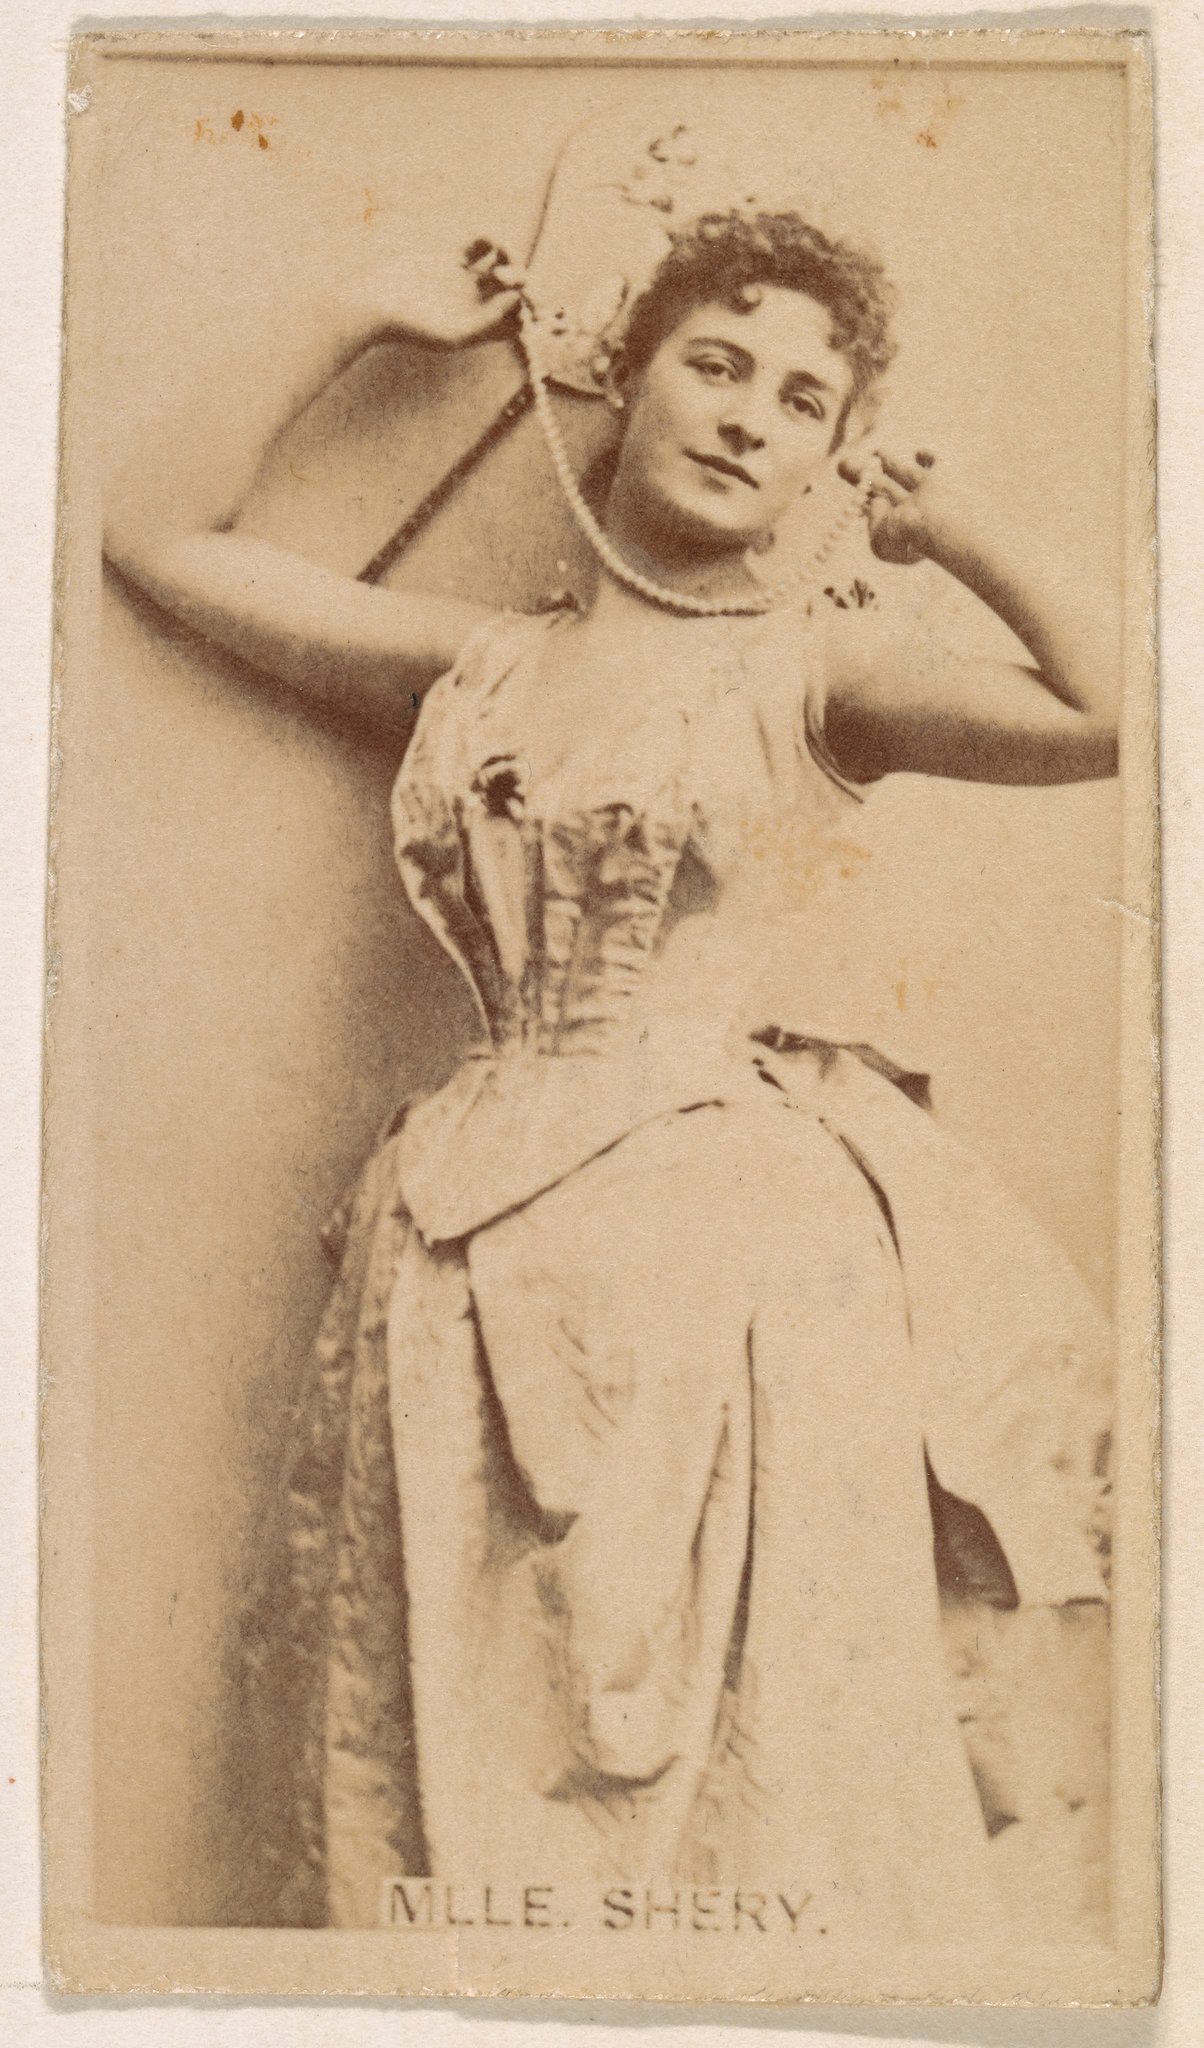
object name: photograph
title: Mlle. Shery, from the Actresses series (N245) issued by Kinney Brothers to promote Sweet Caporal Cigarettes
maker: kinney brothers tobacco company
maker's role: publisher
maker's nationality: american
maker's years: 1869-2011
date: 1890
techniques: albumen silver print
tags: portraits,women,actresses